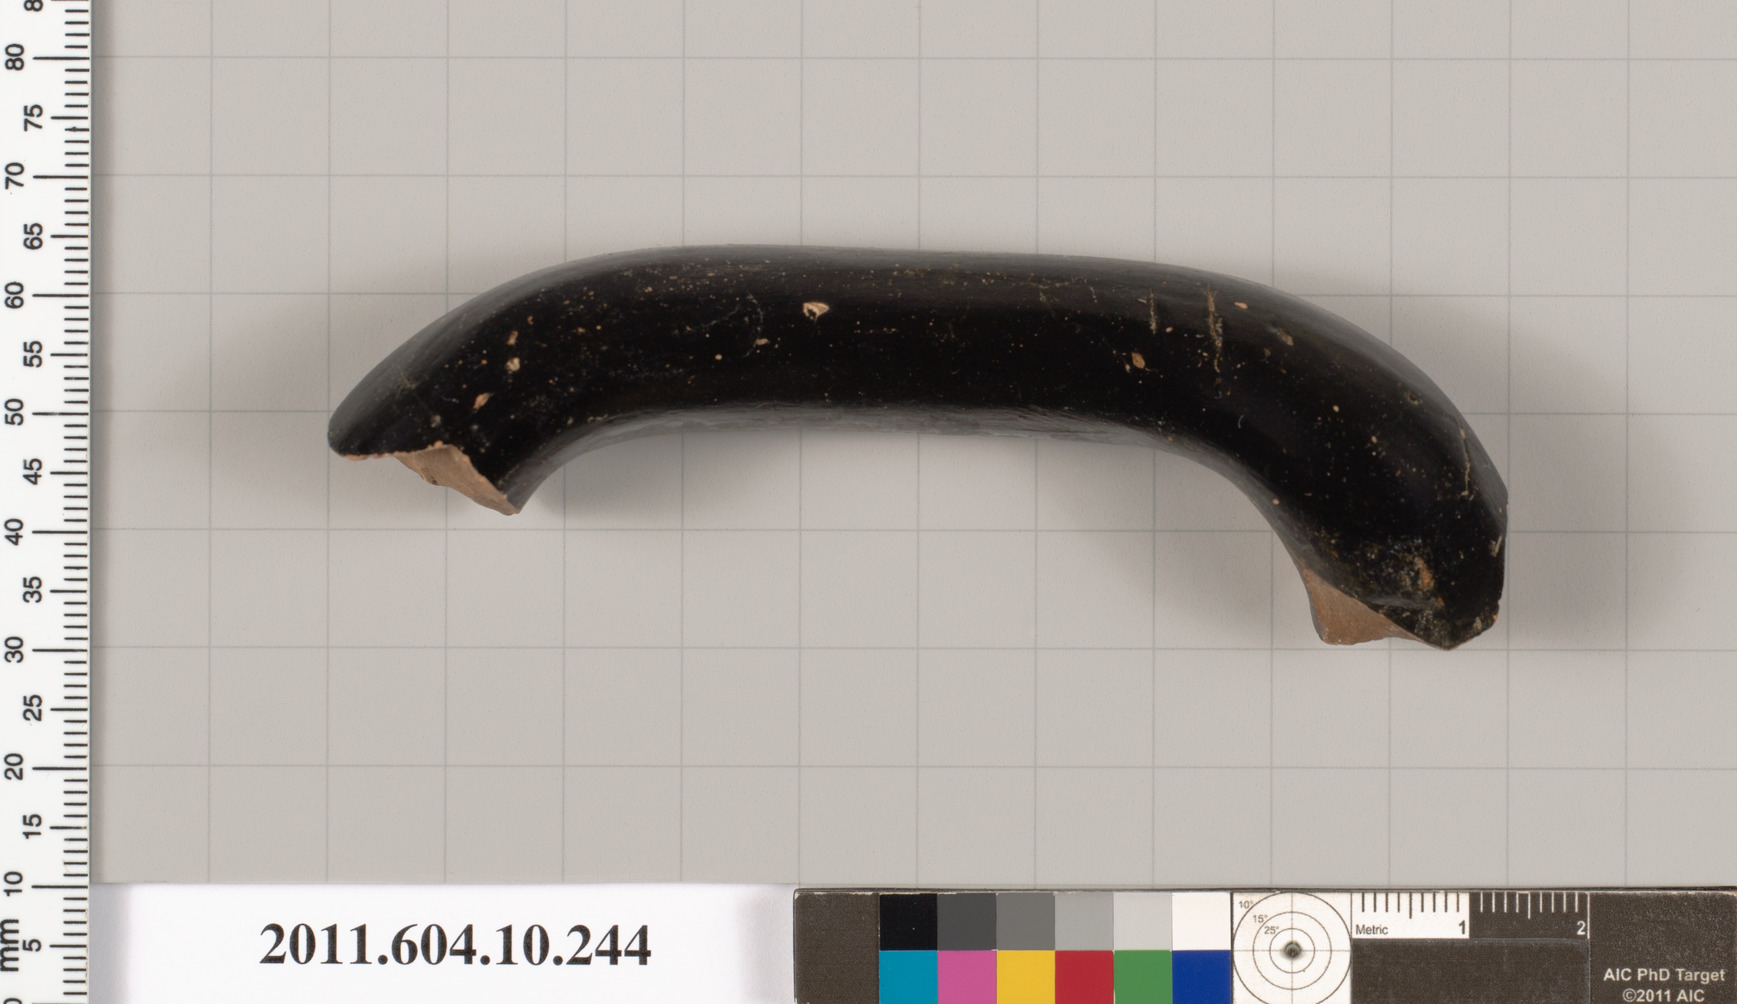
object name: stamnos fragment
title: Terracotta fragment of a stamnos (jar)?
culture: etruscan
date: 600-401 BCE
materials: terracotta